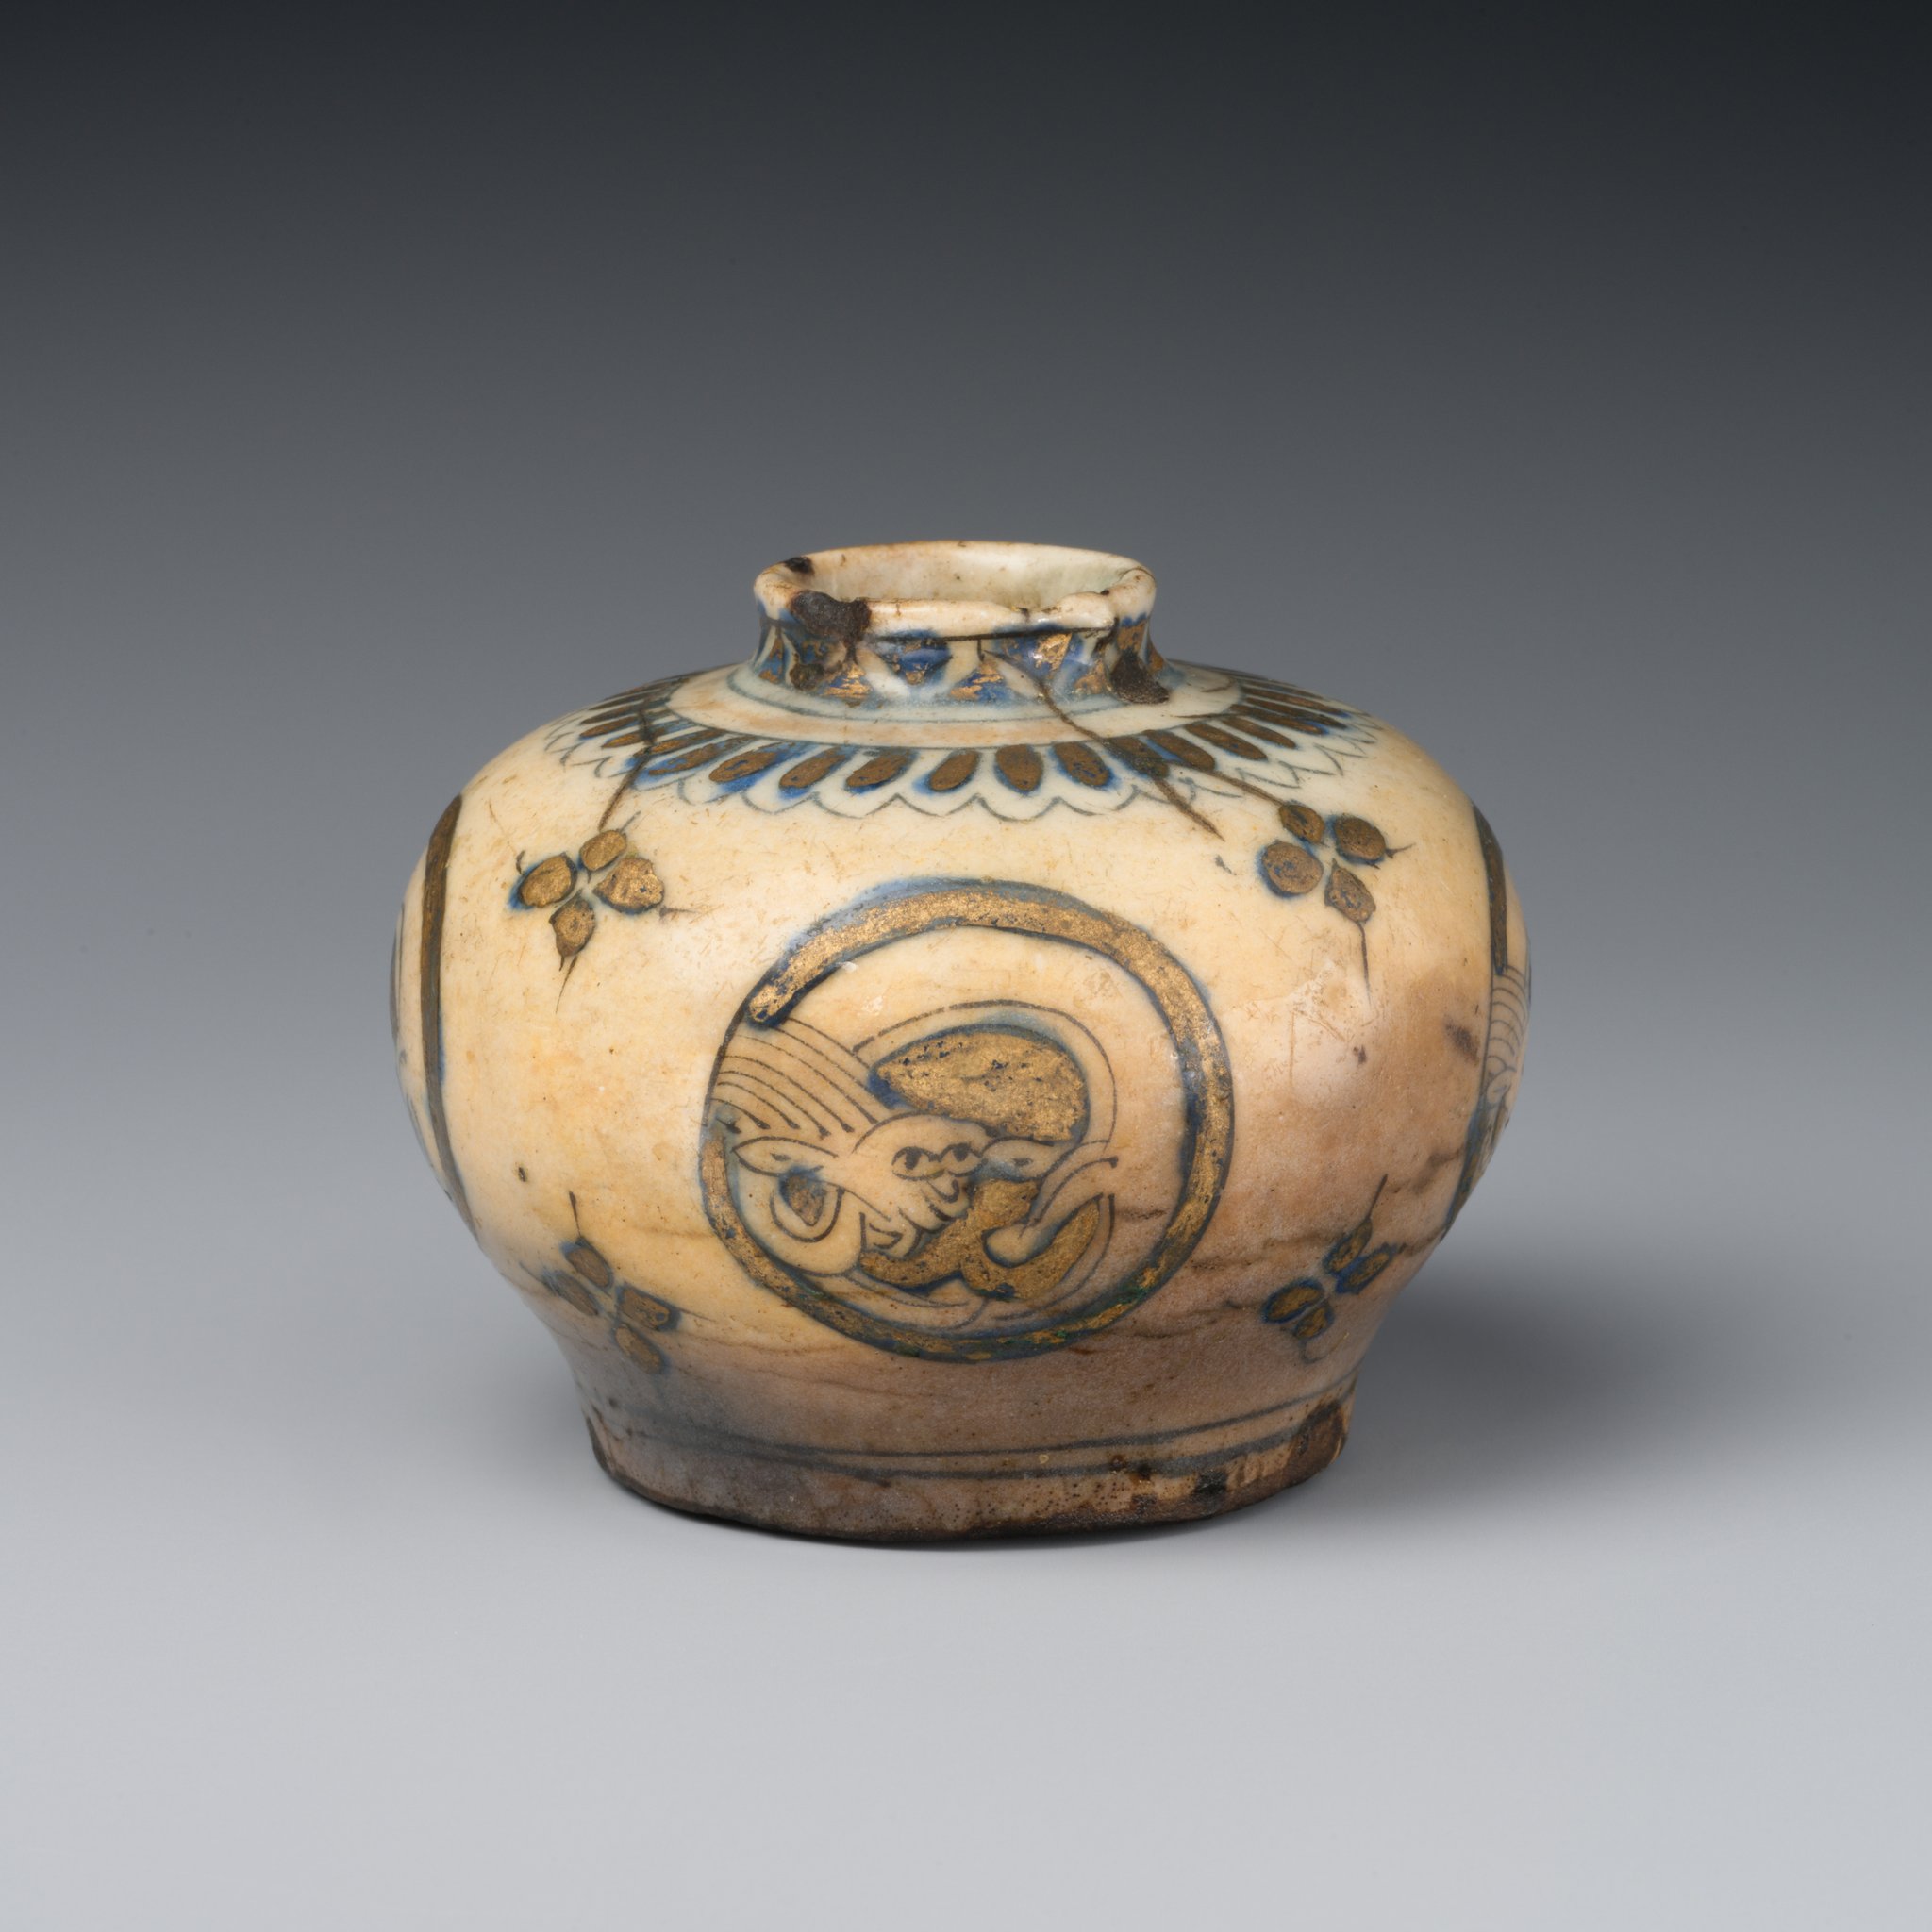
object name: vase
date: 1701-1800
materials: faience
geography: iran